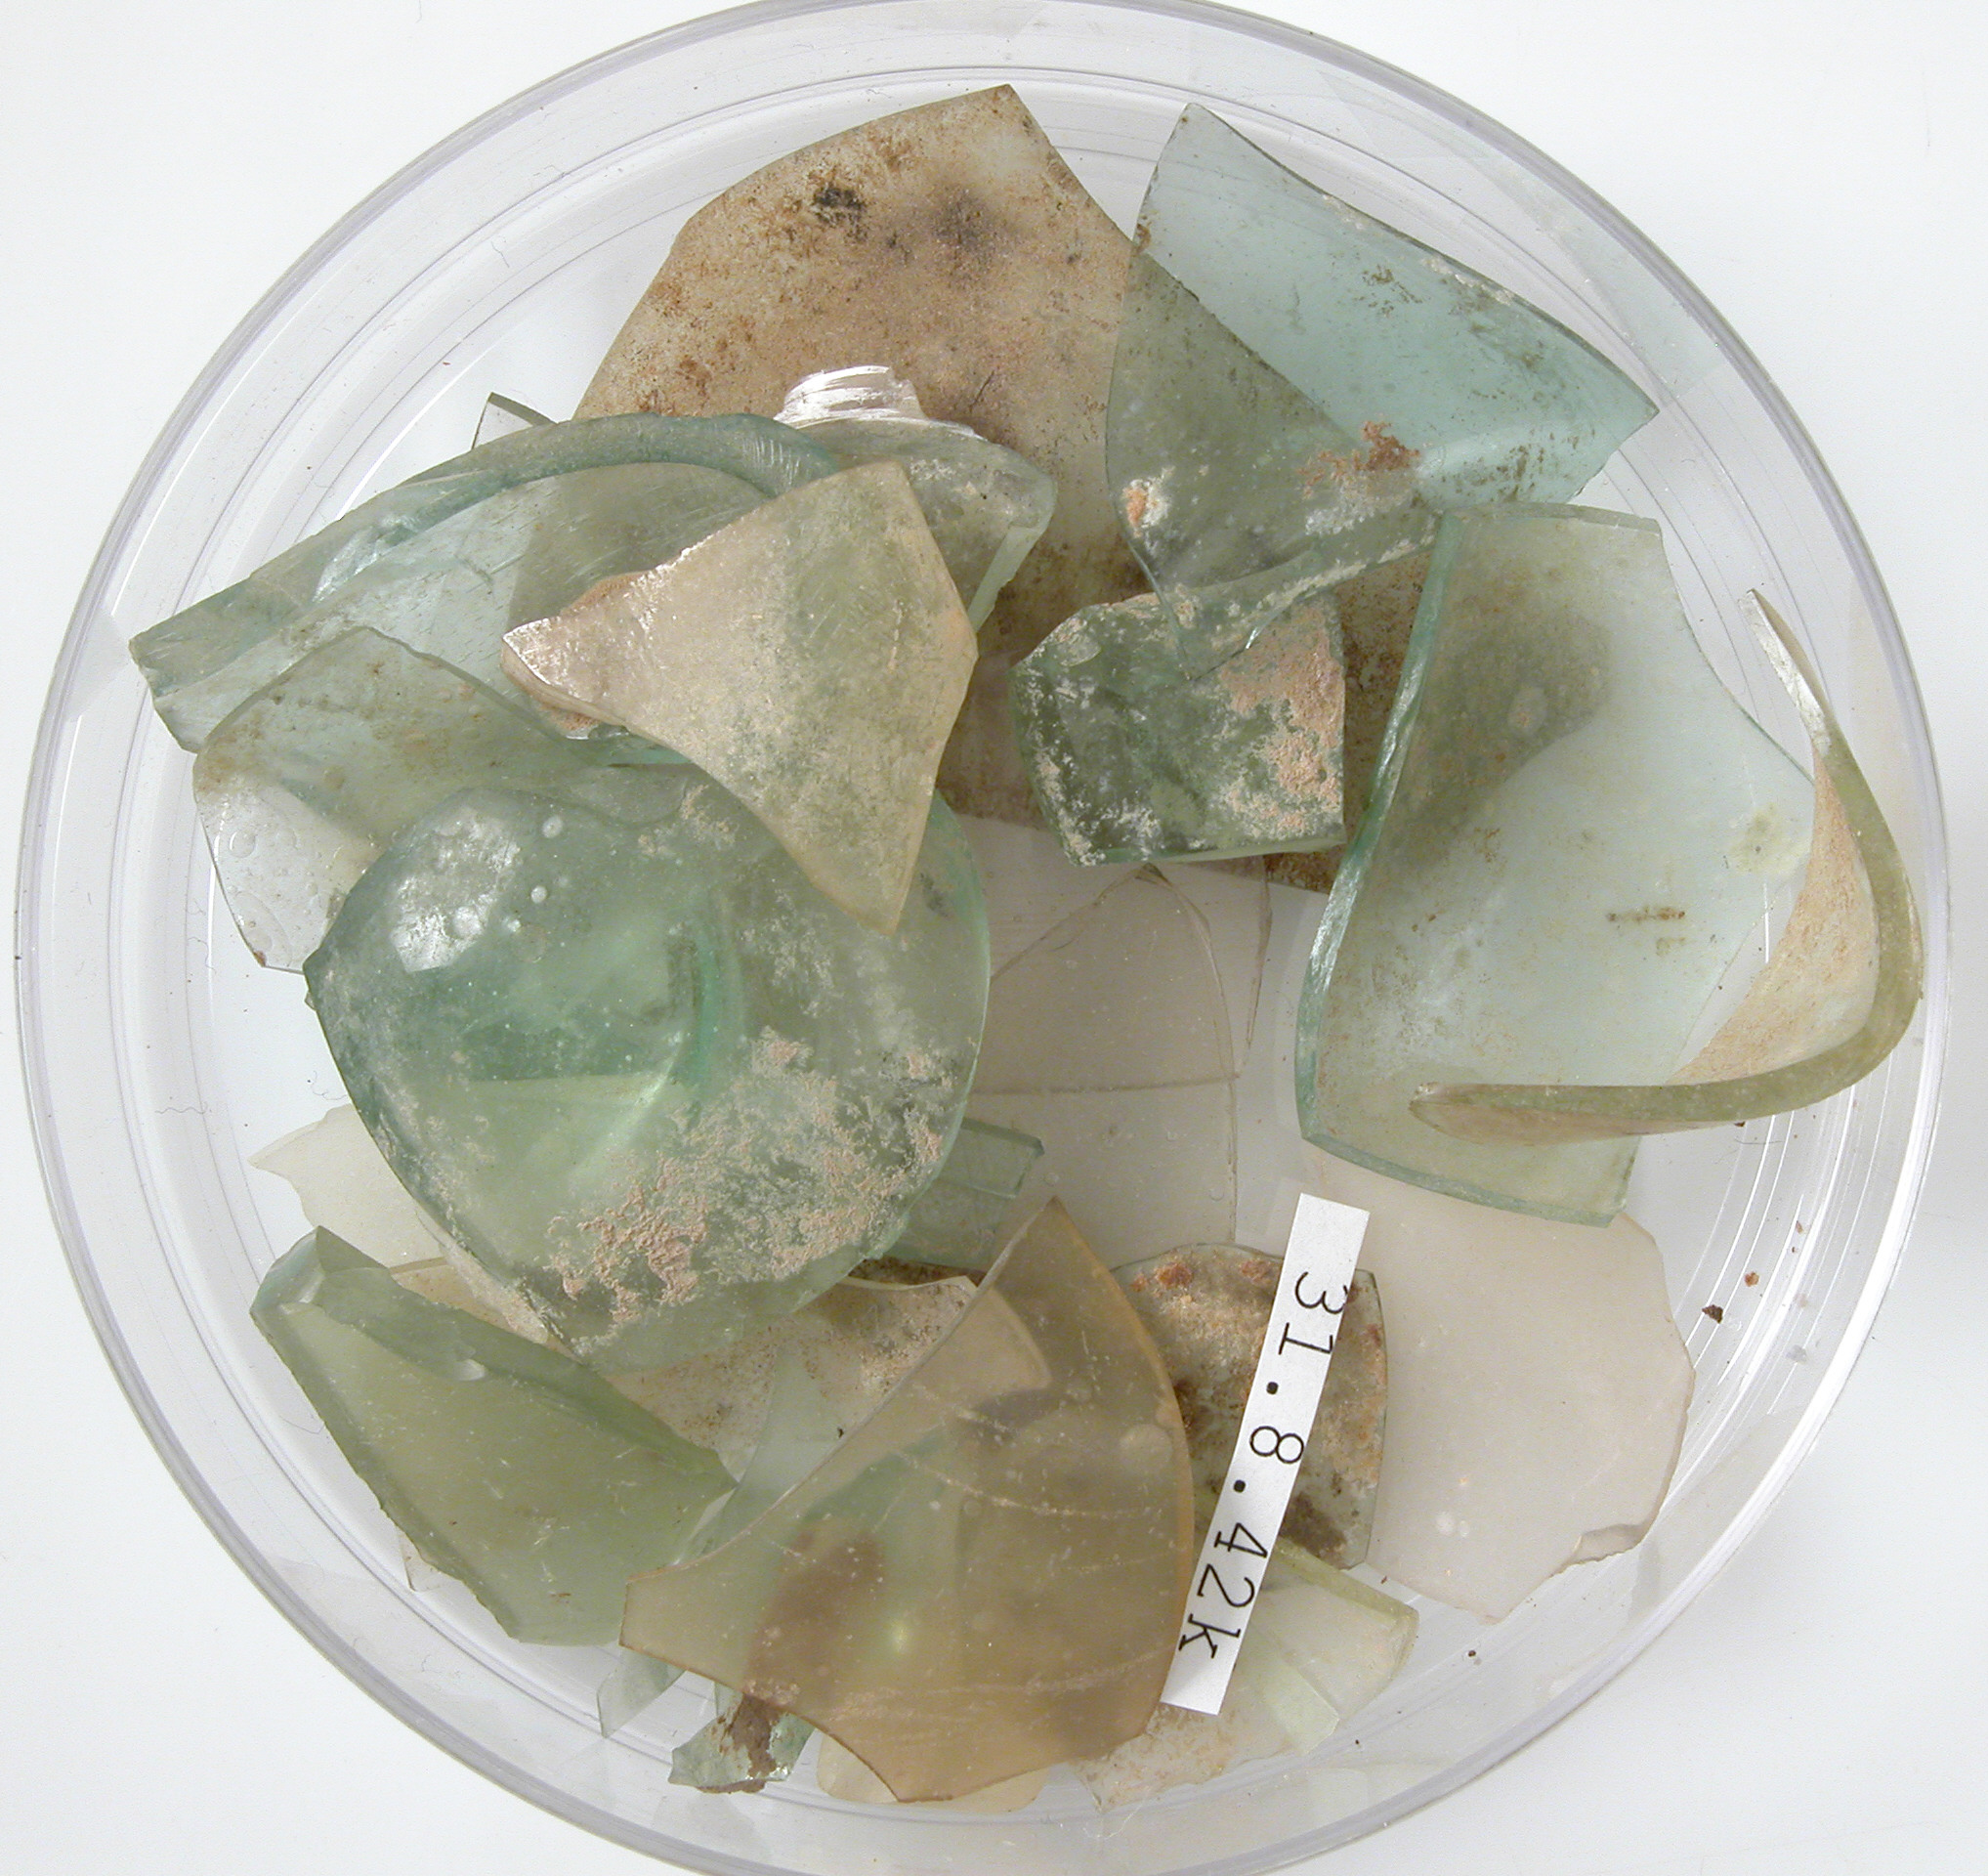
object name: fragment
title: Glass Fragments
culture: coptic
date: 301-400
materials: glass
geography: egypt